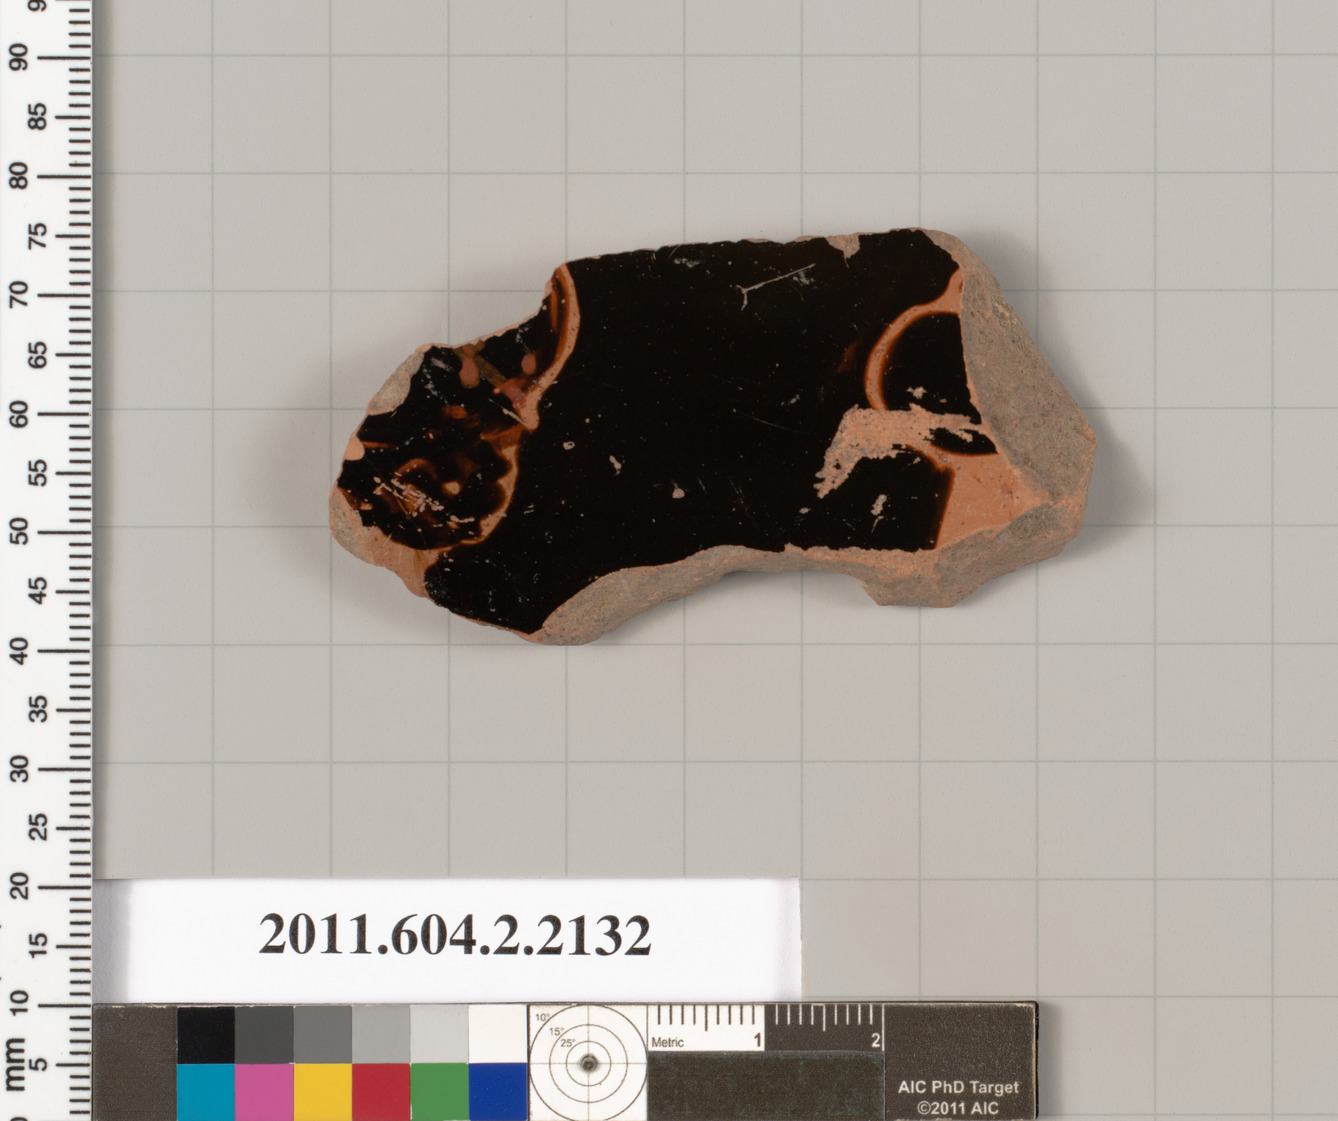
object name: pot fragment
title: Terracotta fragment of a pot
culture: greek, attic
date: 475-451 BCE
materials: terracotta